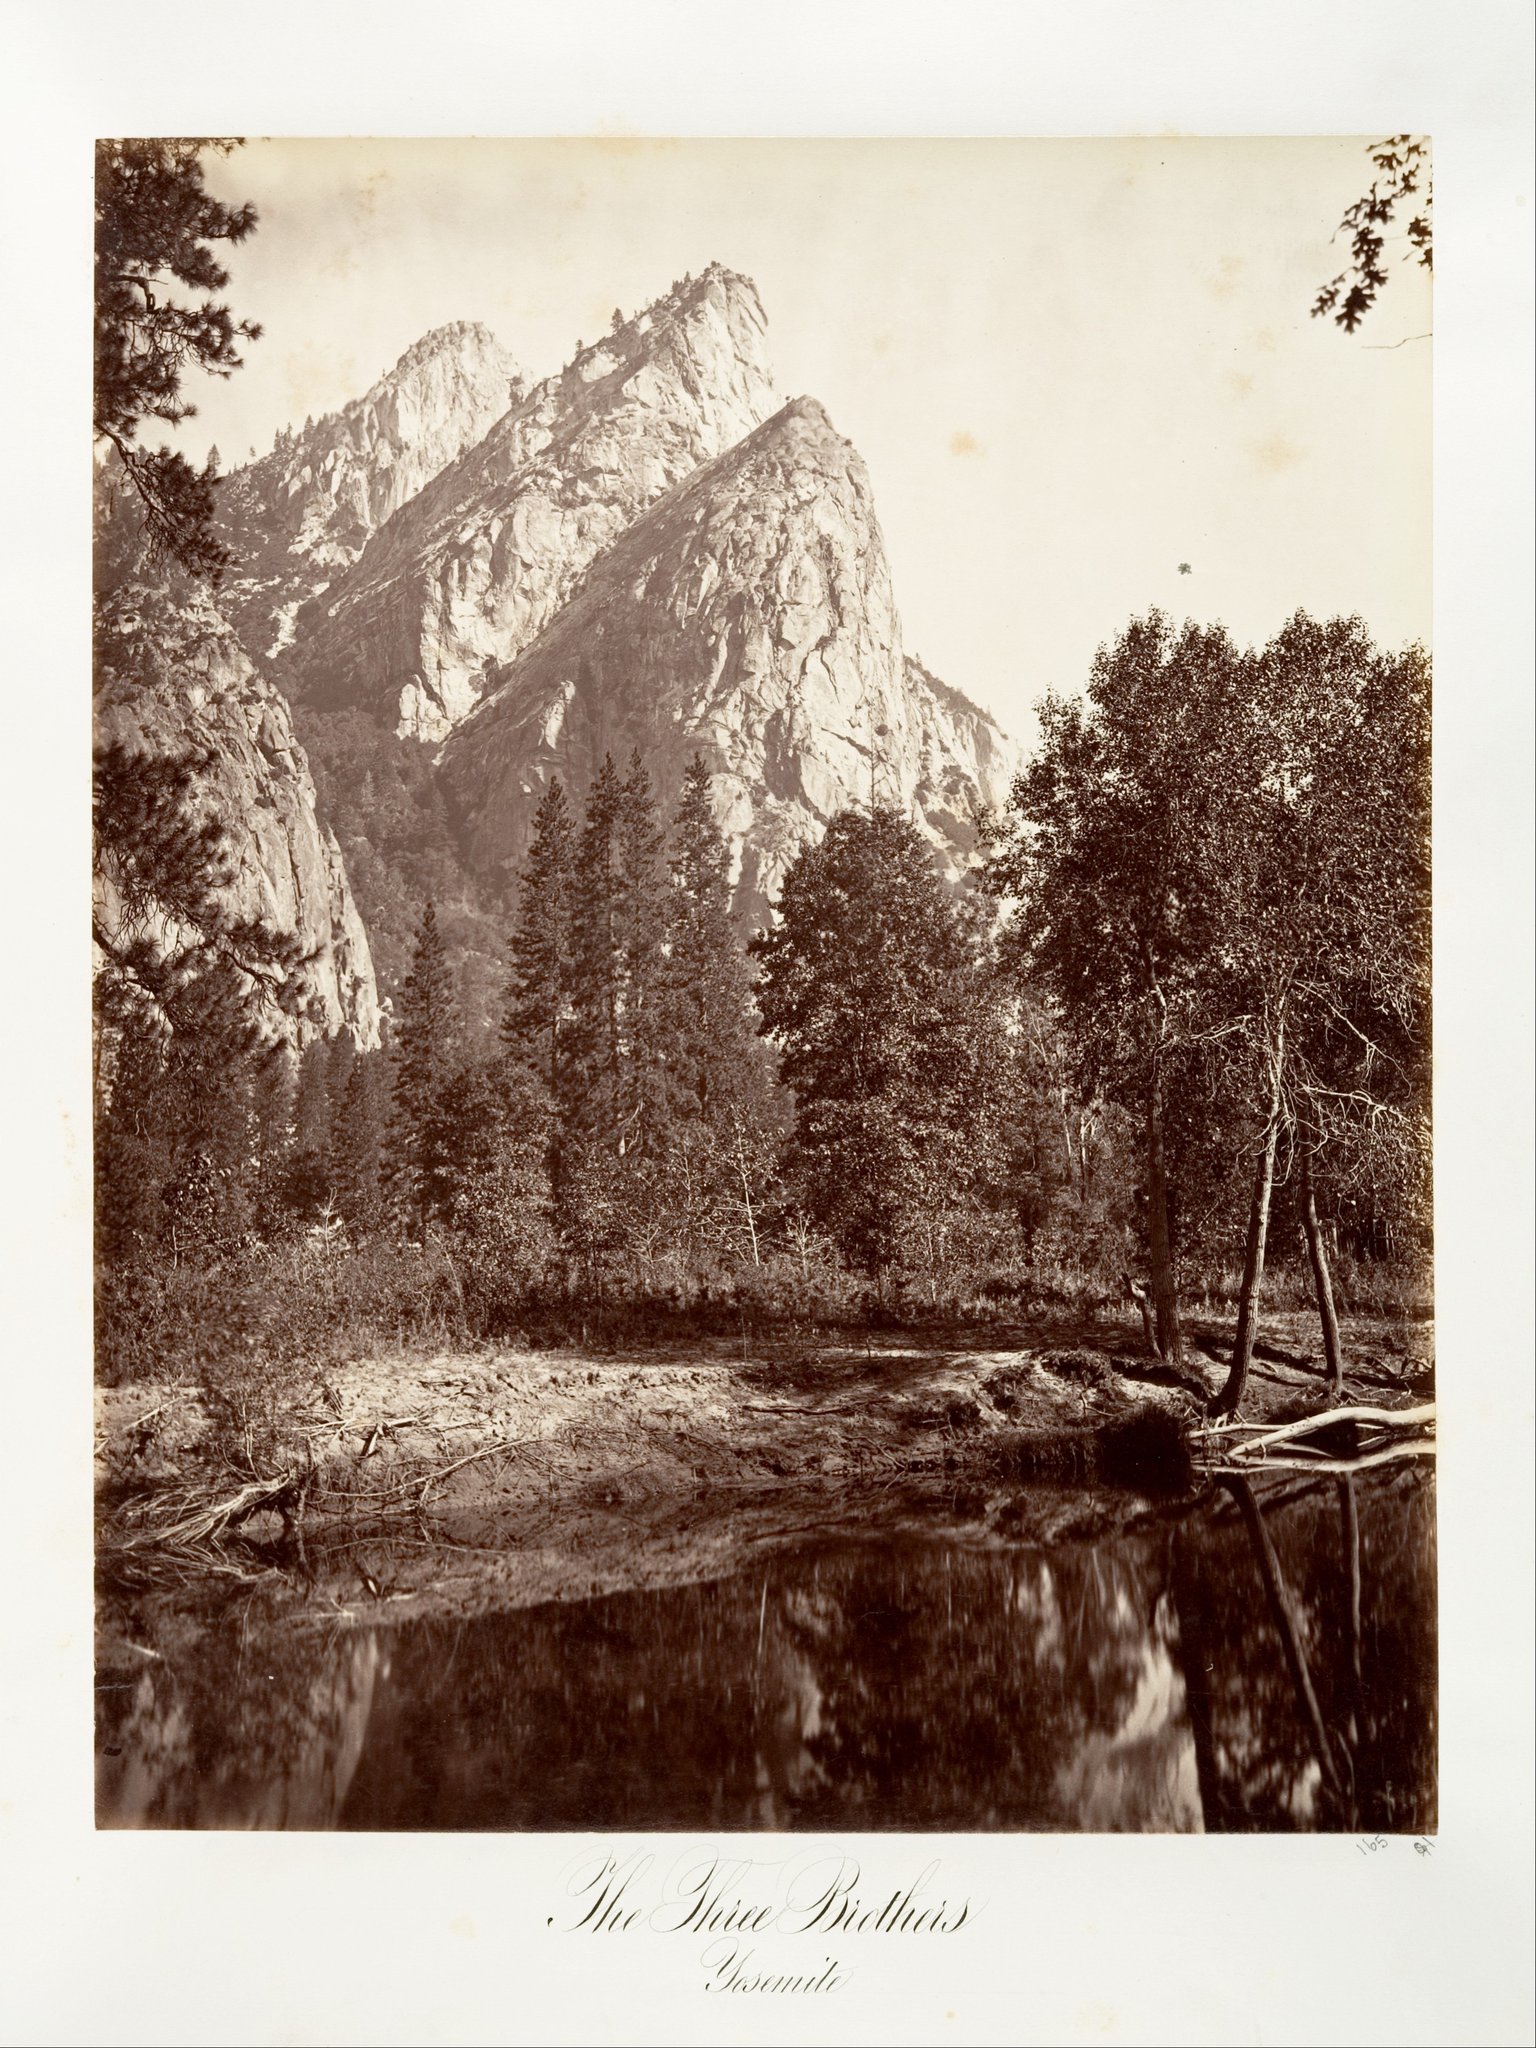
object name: photograph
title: The Three Brothers, Yosemite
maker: carleton e. watkins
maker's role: artist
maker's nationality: american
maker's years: 1829-1916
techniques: albumen silver print, glass negative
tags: mountains,landscapes